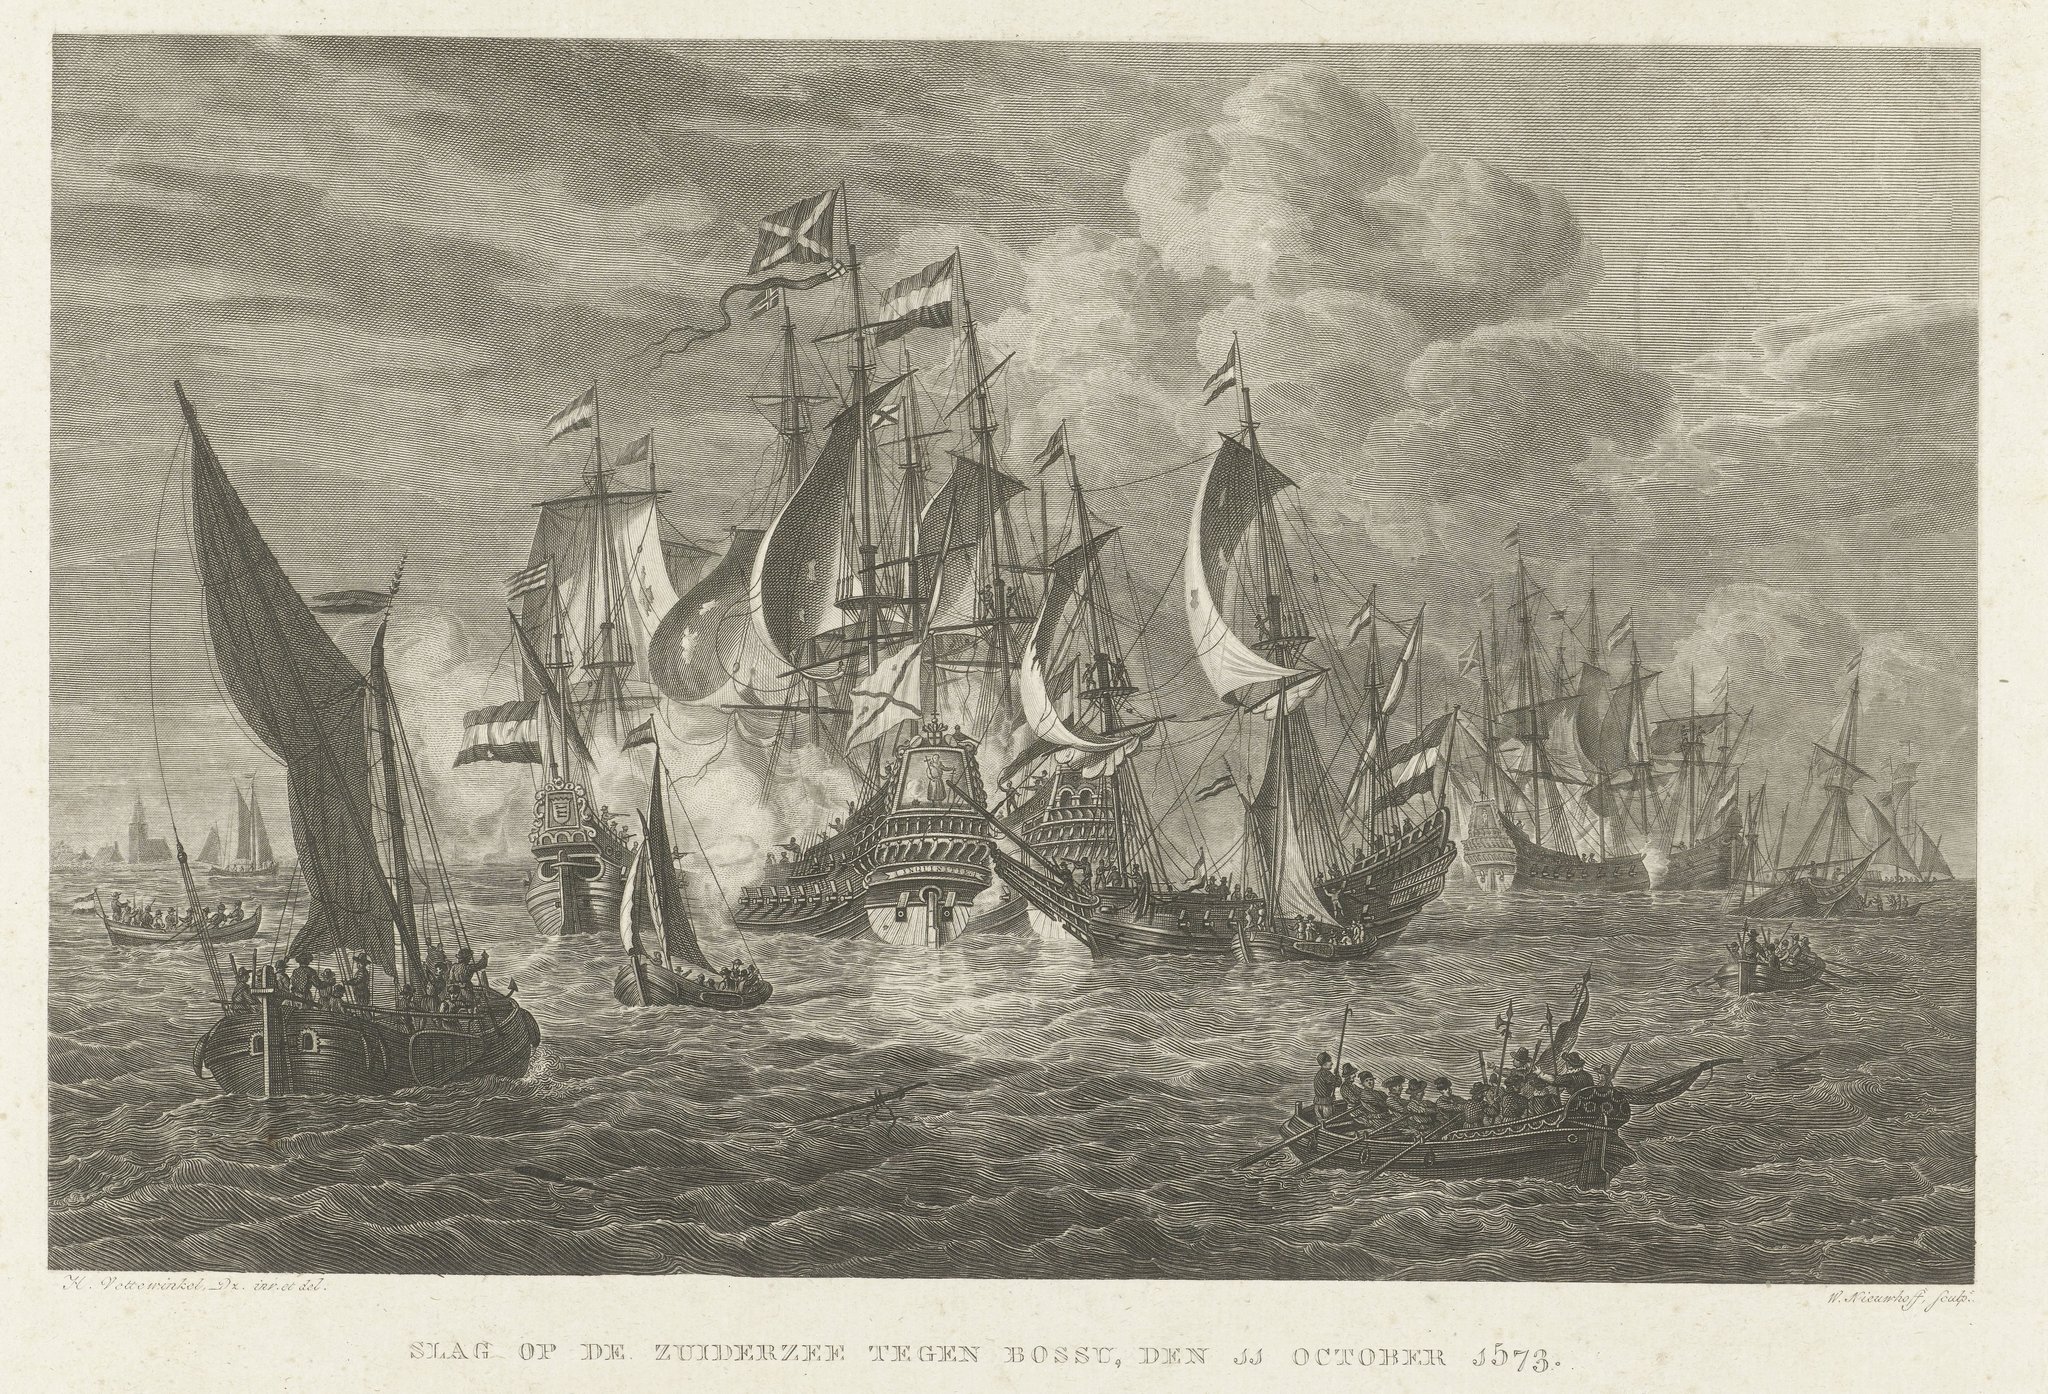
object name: print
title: De slag op de Zuiderzee tegen Bossu, 1573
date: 1829-1831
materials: paper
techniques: etching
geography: netherlands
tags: antwerp, earl, politician, battle (+ naval force), zuiderzee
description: De slag op de Zuiderzee, 11 oktober 1573. Zeeslag waarbij de vloot van de watergeuzen onder leiding van Cornelis Dirkszoon van Monnickendam de Spaanse vloot van Bossu verslaat. In het midden vuren de schepen op elkaar, op de voorgrond een sloep en enkele andere kleinere vaartuigen.